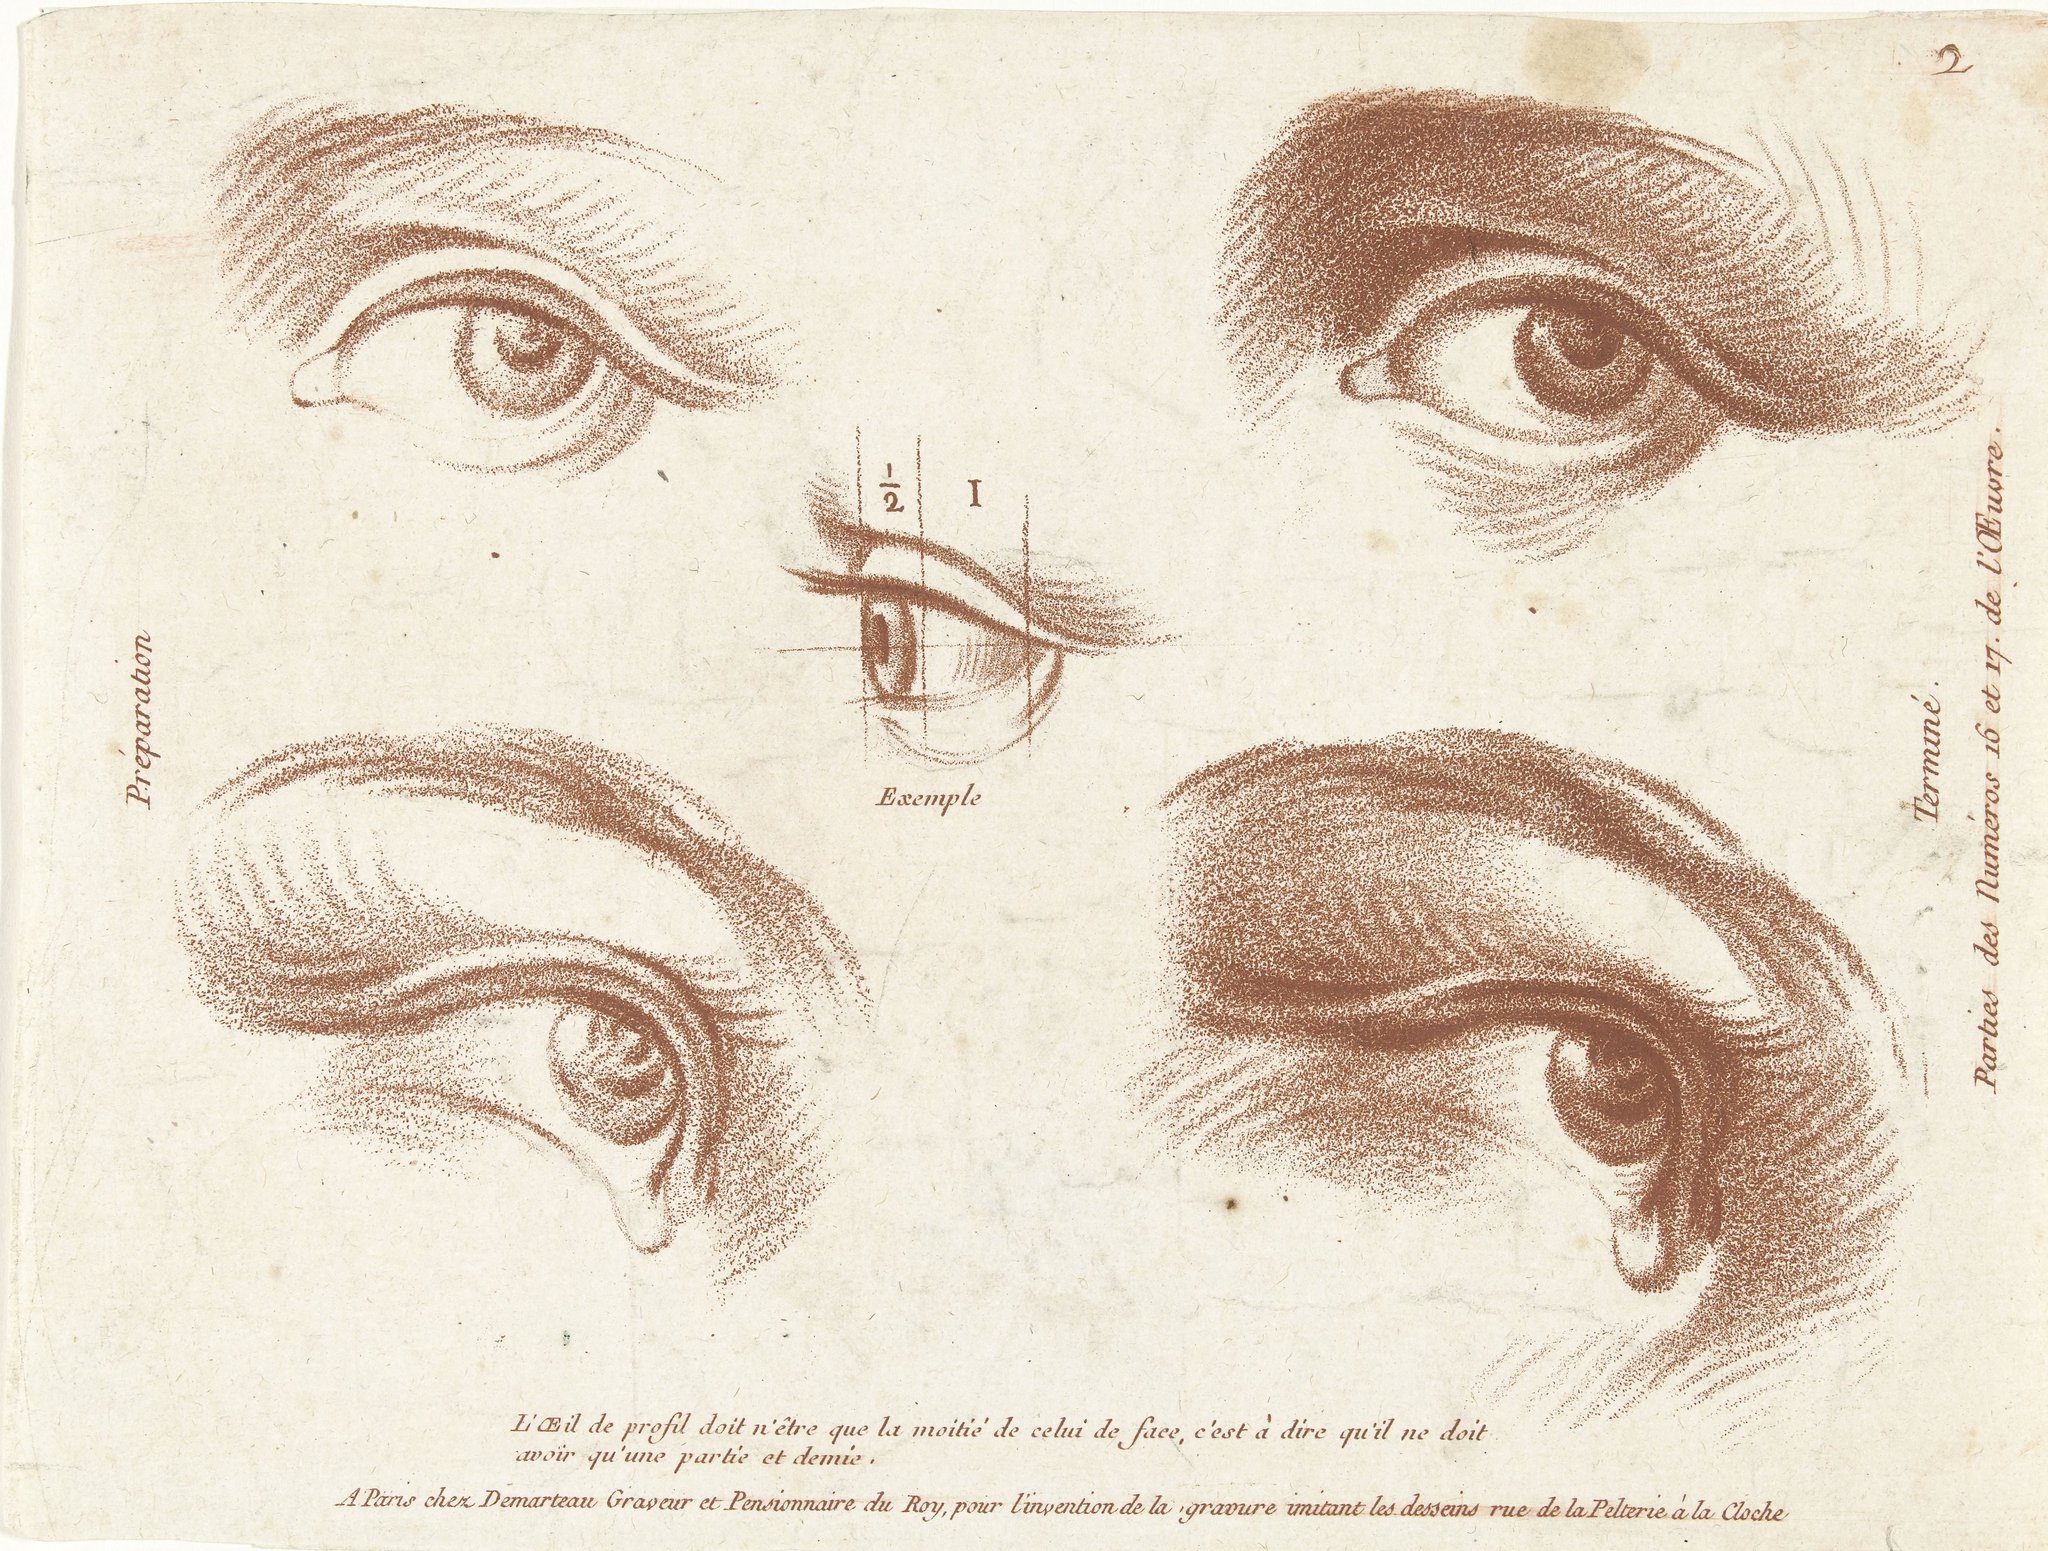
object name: print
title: Livres de principes de dessein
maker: gilles demarteau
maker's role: print maker, publisher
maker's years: 1722-1776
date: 1732-1776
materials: paper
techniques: printmaking, etching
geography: paris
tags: eyes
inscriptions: collector's mark: Lugt 2228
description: Studieblad met voorbeelden van ogen in verschillende fasen van afwerking in de tekening, met instucties voor de juiste proporties. Los blad uit serie Livres de principes de dessein.